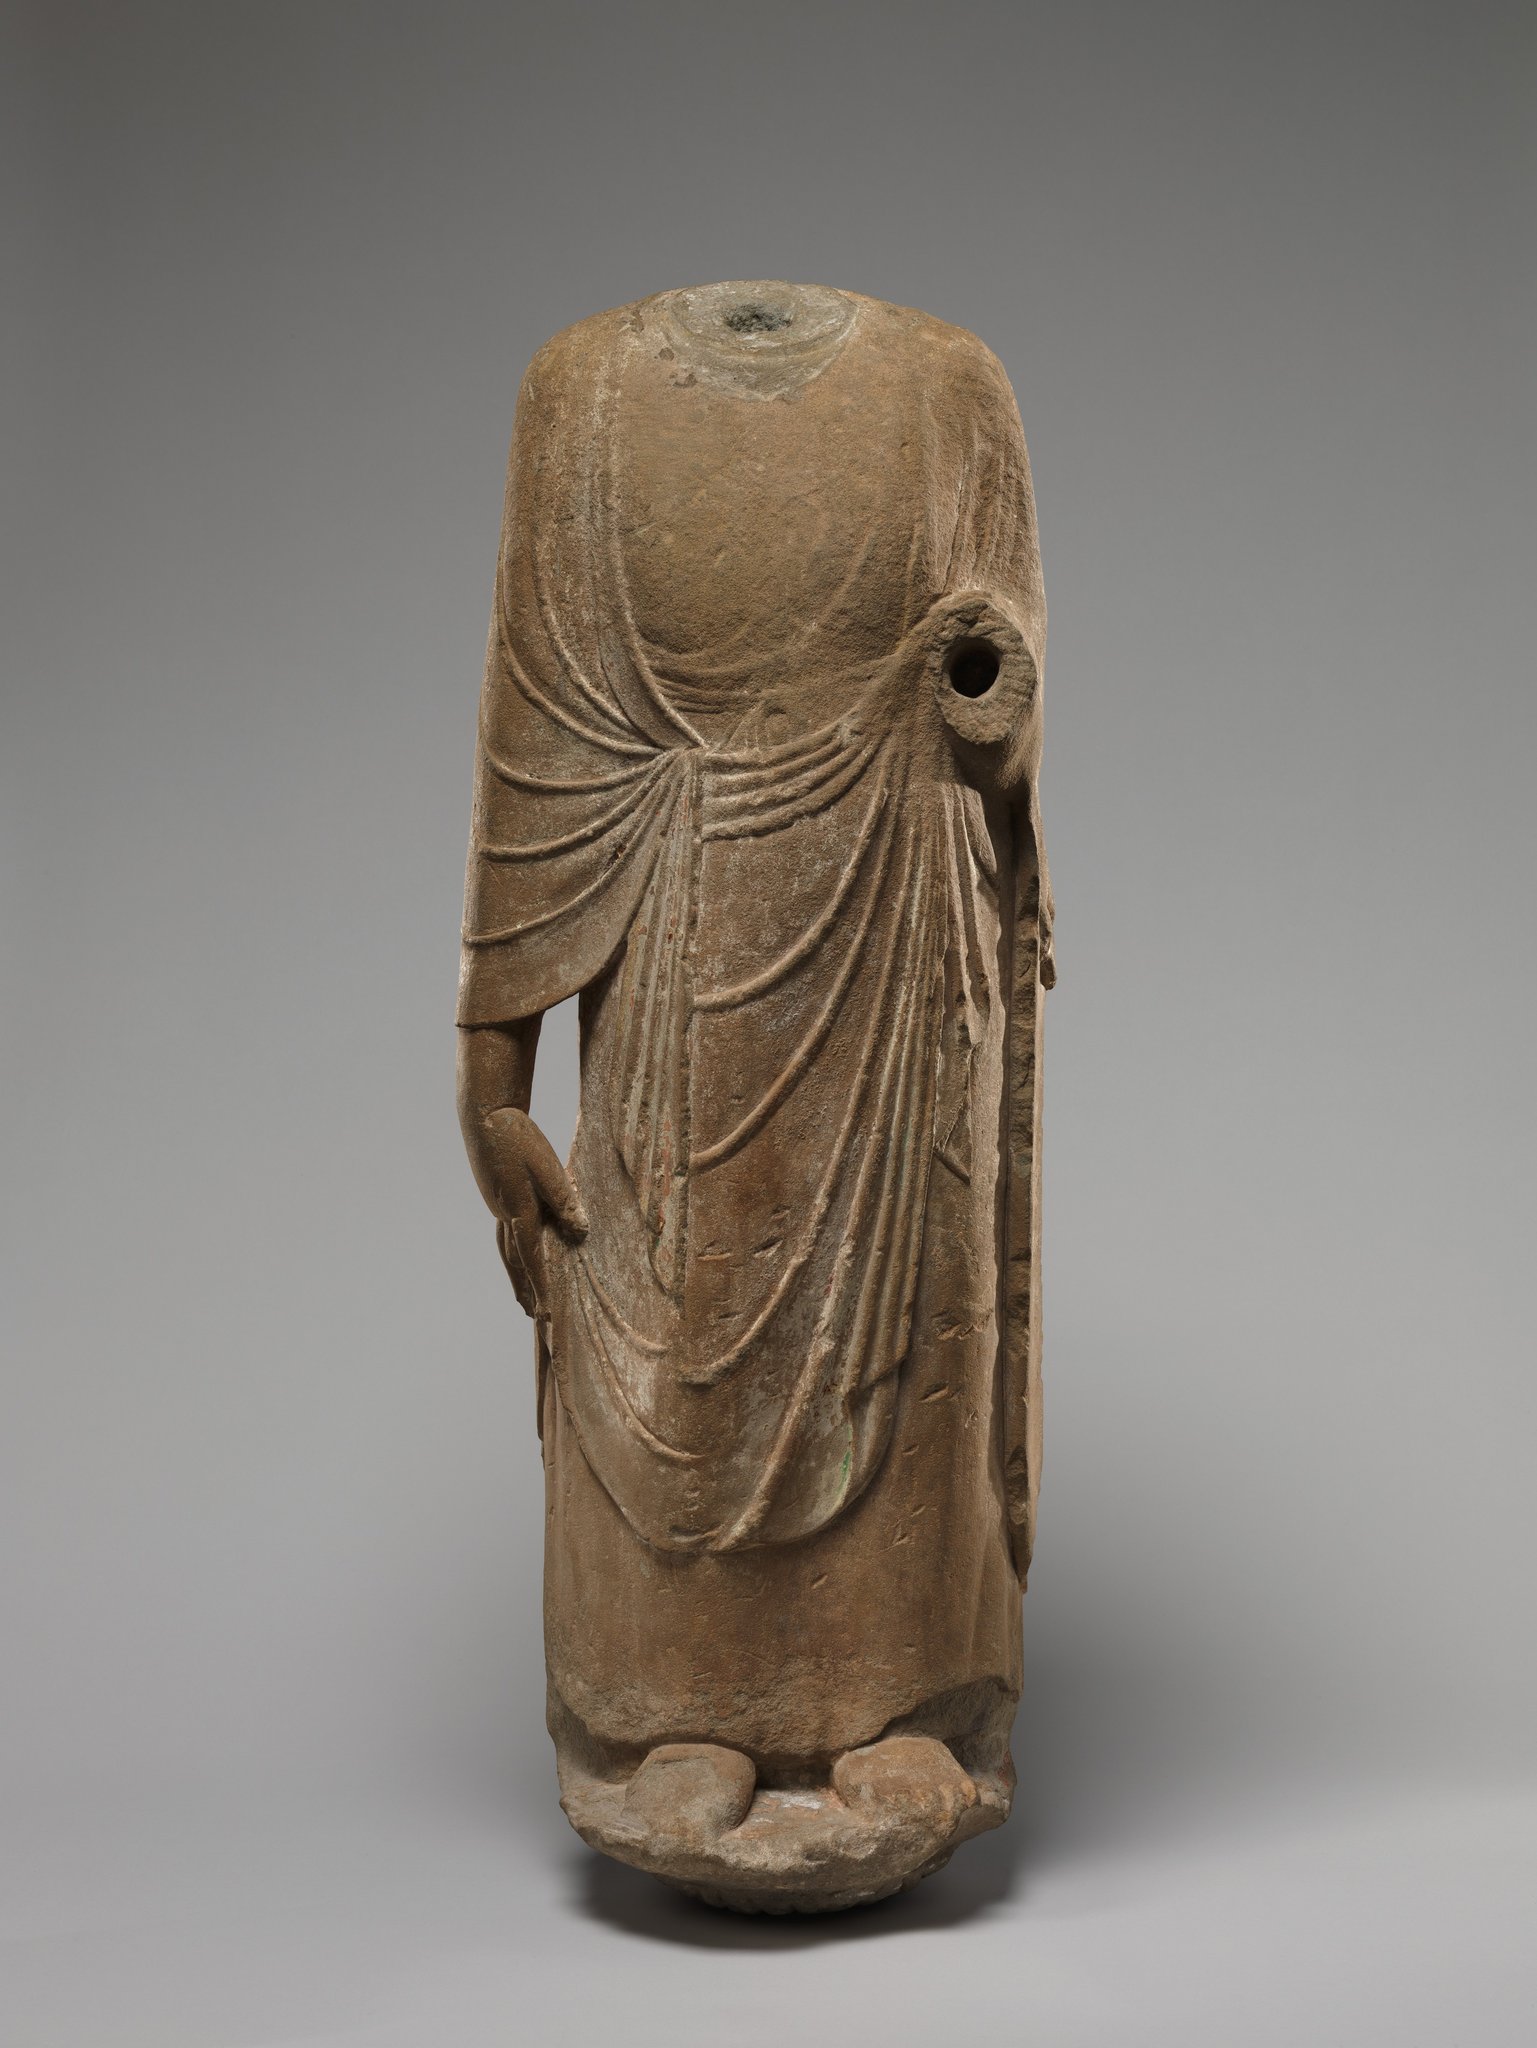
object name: headless figure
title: Buddhist attendant (possibly Kasyapa)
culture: chinese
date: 567-700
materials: pigment, stone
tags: monks